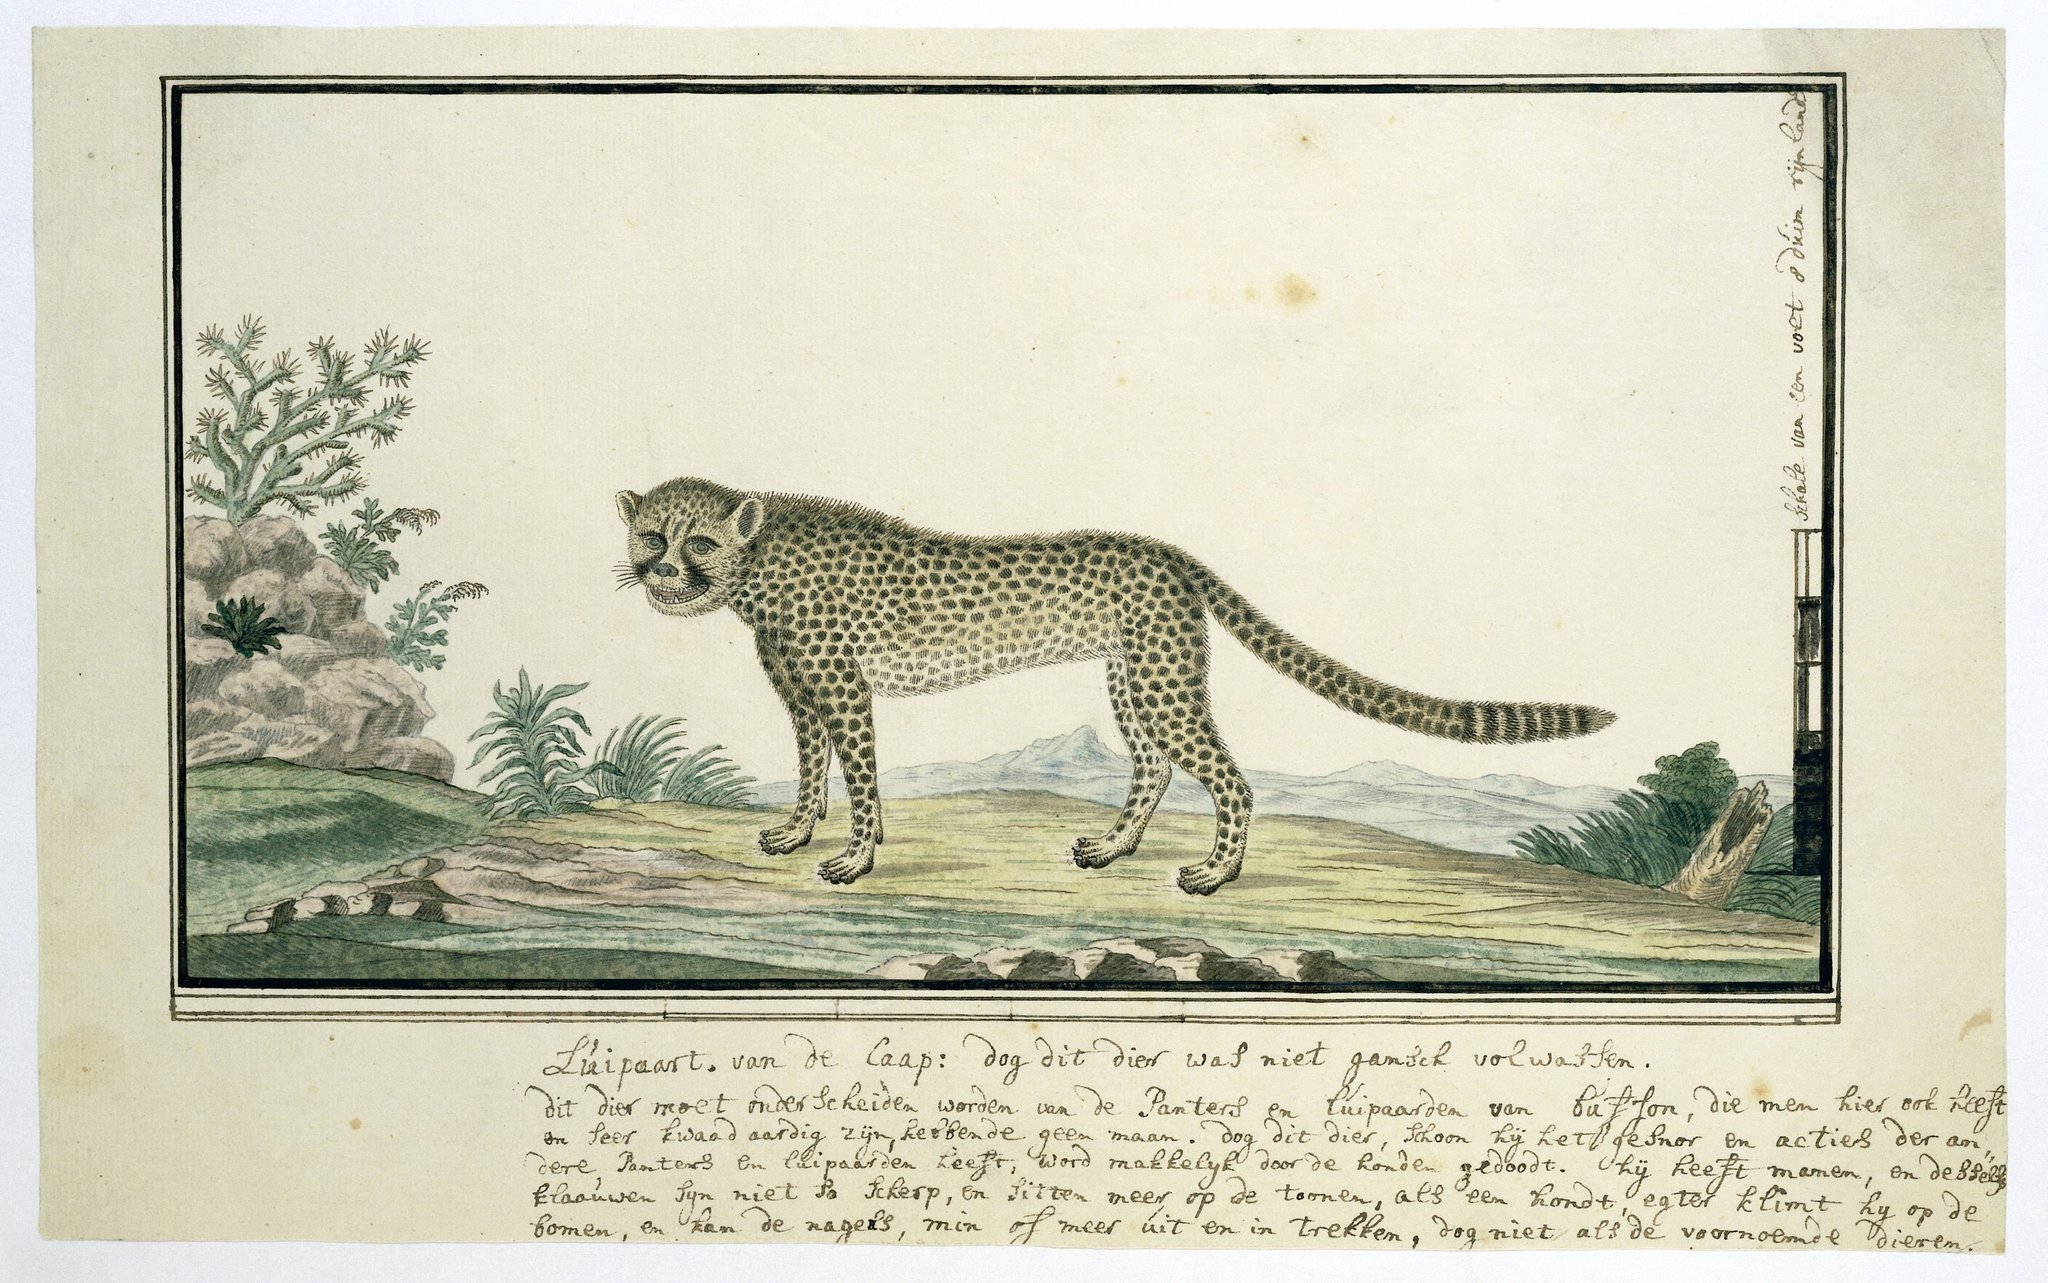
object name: dierstudie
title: Acinonyx jubatus (Cheetah)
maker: robert jacob gordon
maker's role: draughtsman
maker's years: 1743-1795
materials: chalk, ink, paper, pencil, watercolor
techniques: brush, pen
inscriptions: annotation: ‘Luipaart, van de Caap : dog dit dier was niet gansch volwassen. / .....’